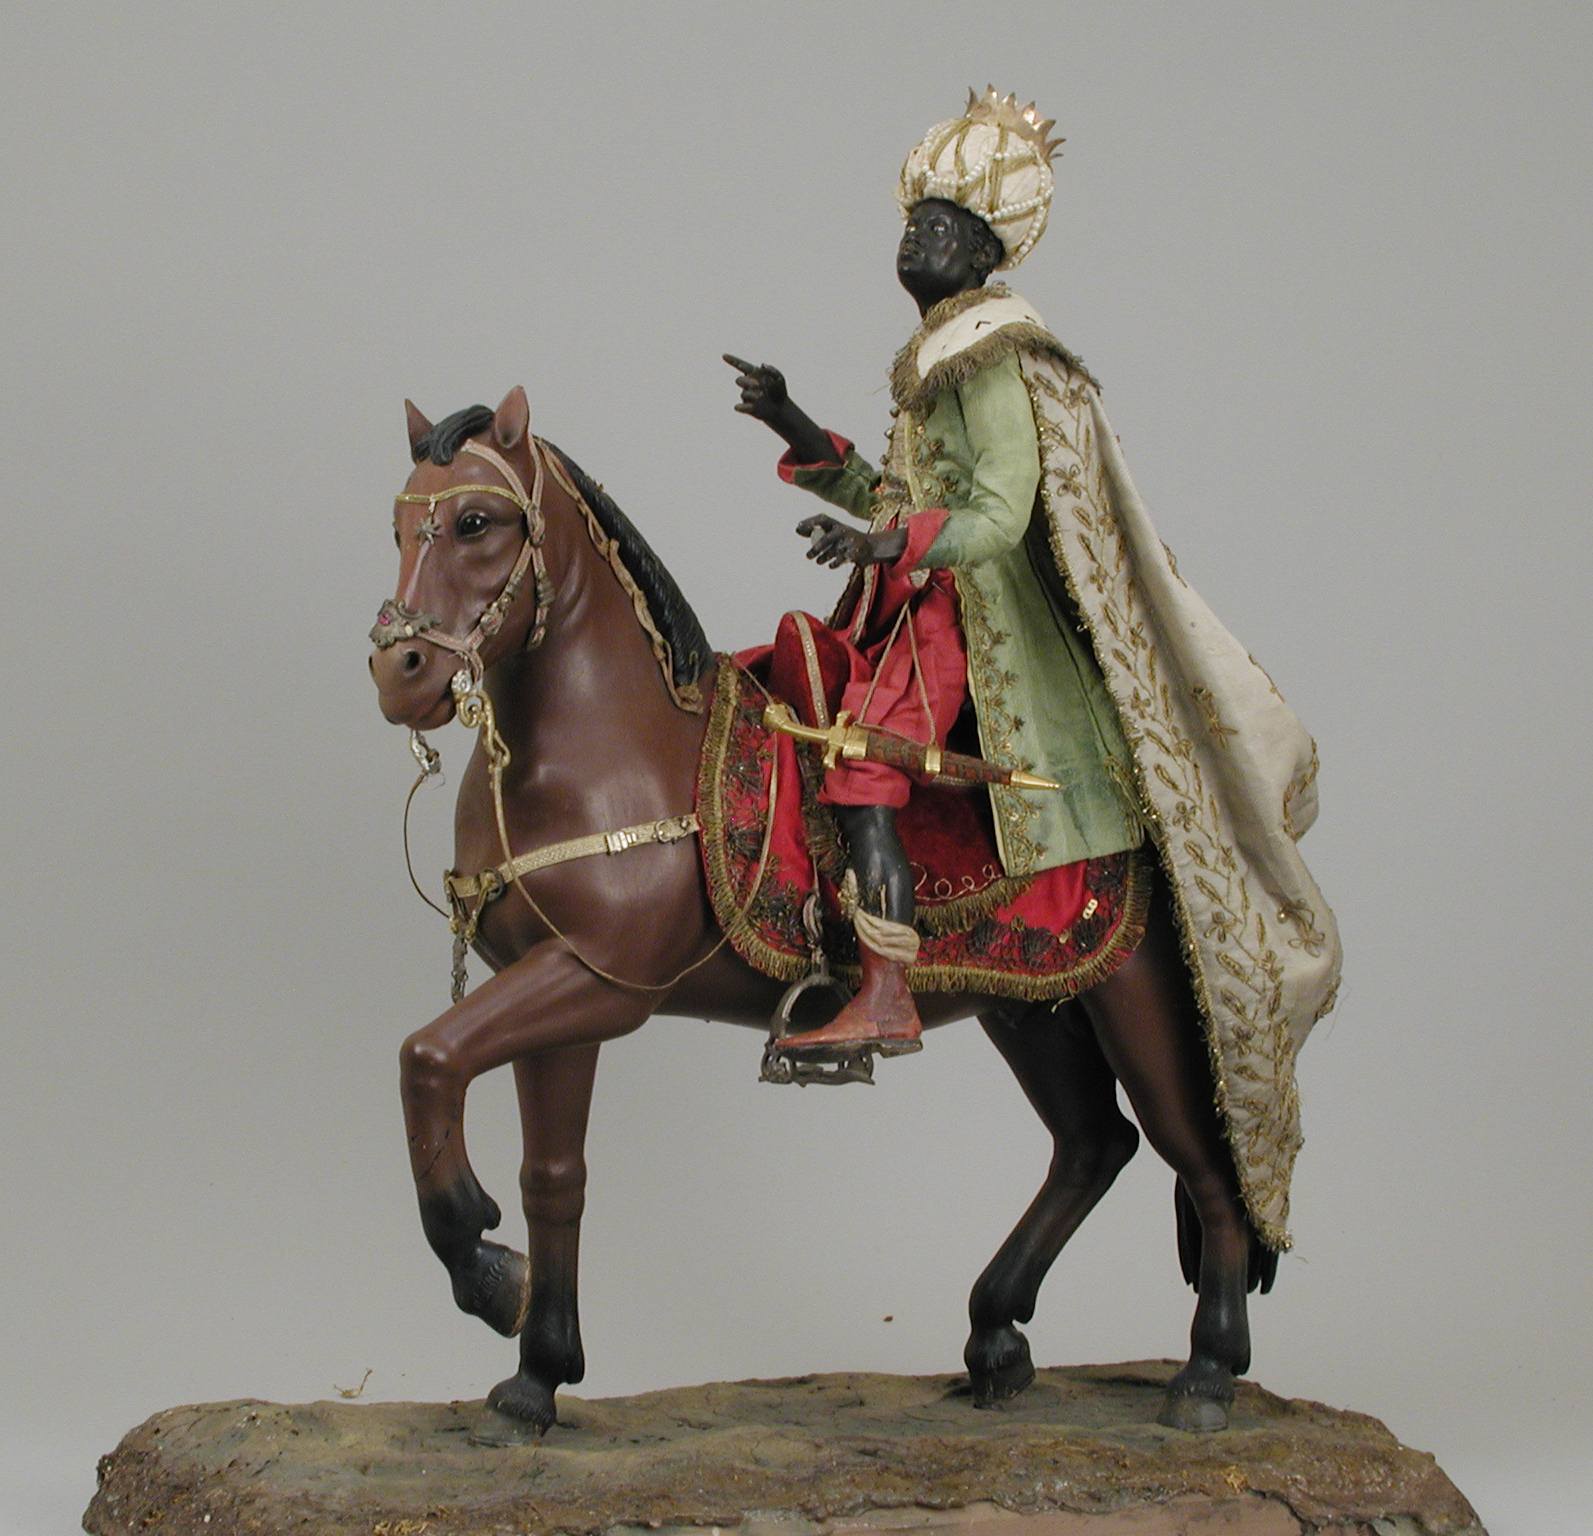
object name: crèche figure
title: Moorish king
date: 1751-1800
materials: coral, glass, gold, metal thread, pearl, textile, silk, silver, silver gilt, terracotta, fiber, velvet, metal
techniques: polychrome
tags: kings,horses